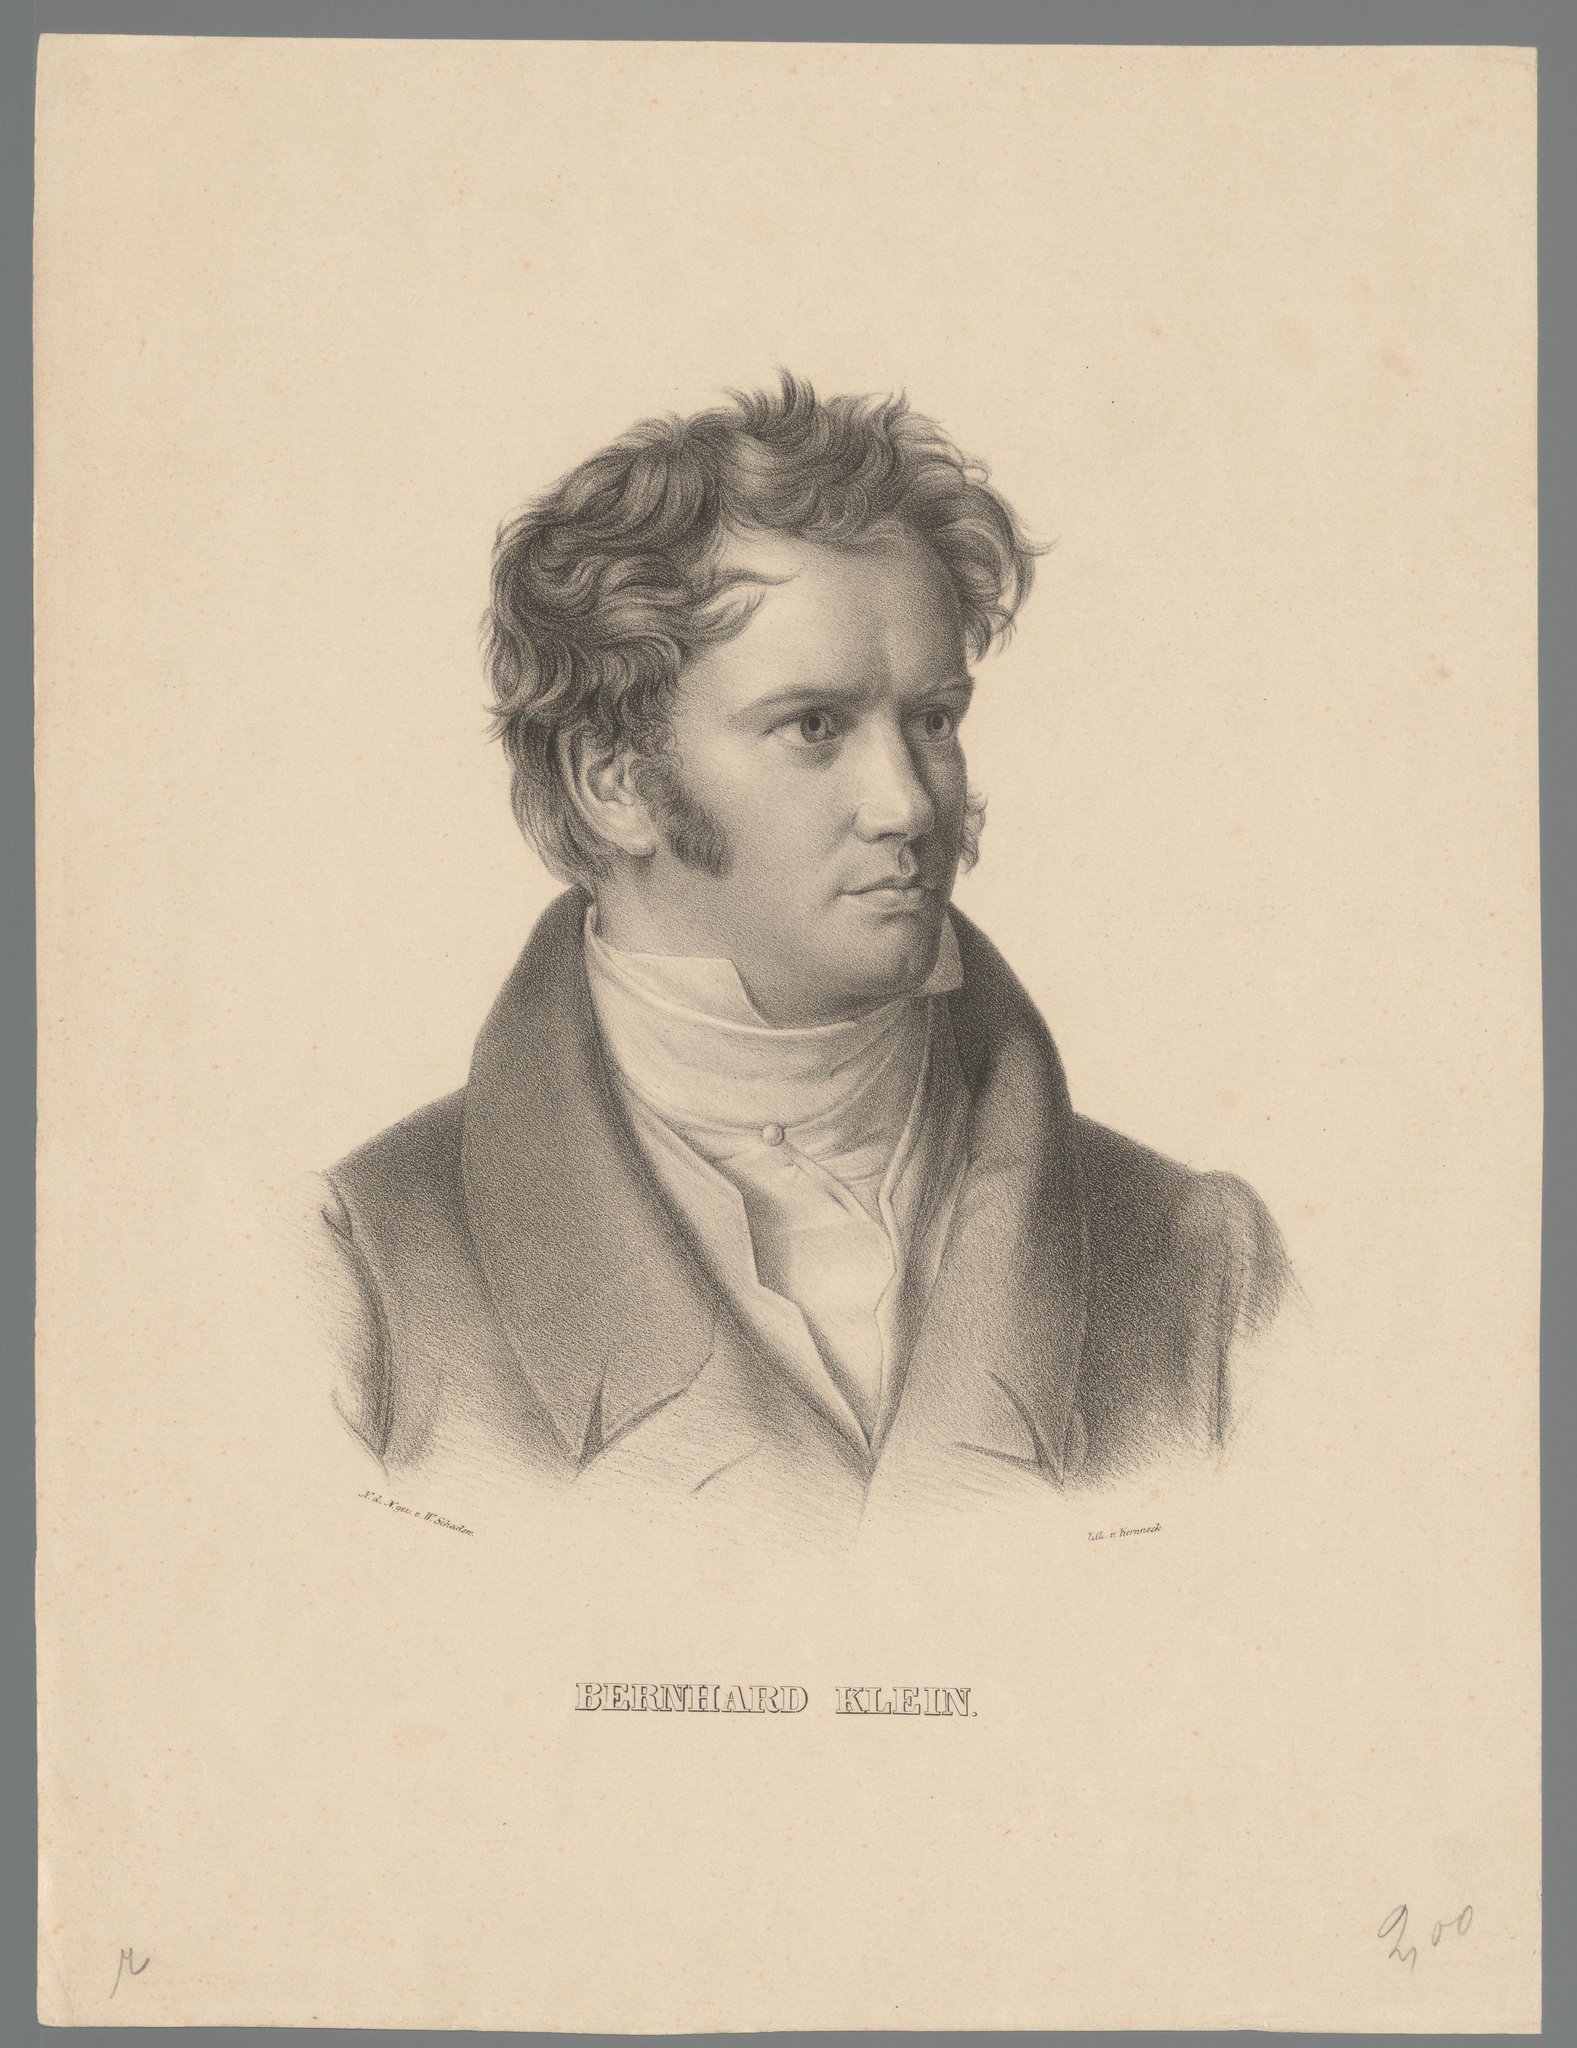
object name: print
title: Portret van Bernhard Klein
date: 1823-1905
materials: paper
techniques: lithograph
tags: historical persons, portrait of composer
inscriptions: collector's mark: Lugt 2228